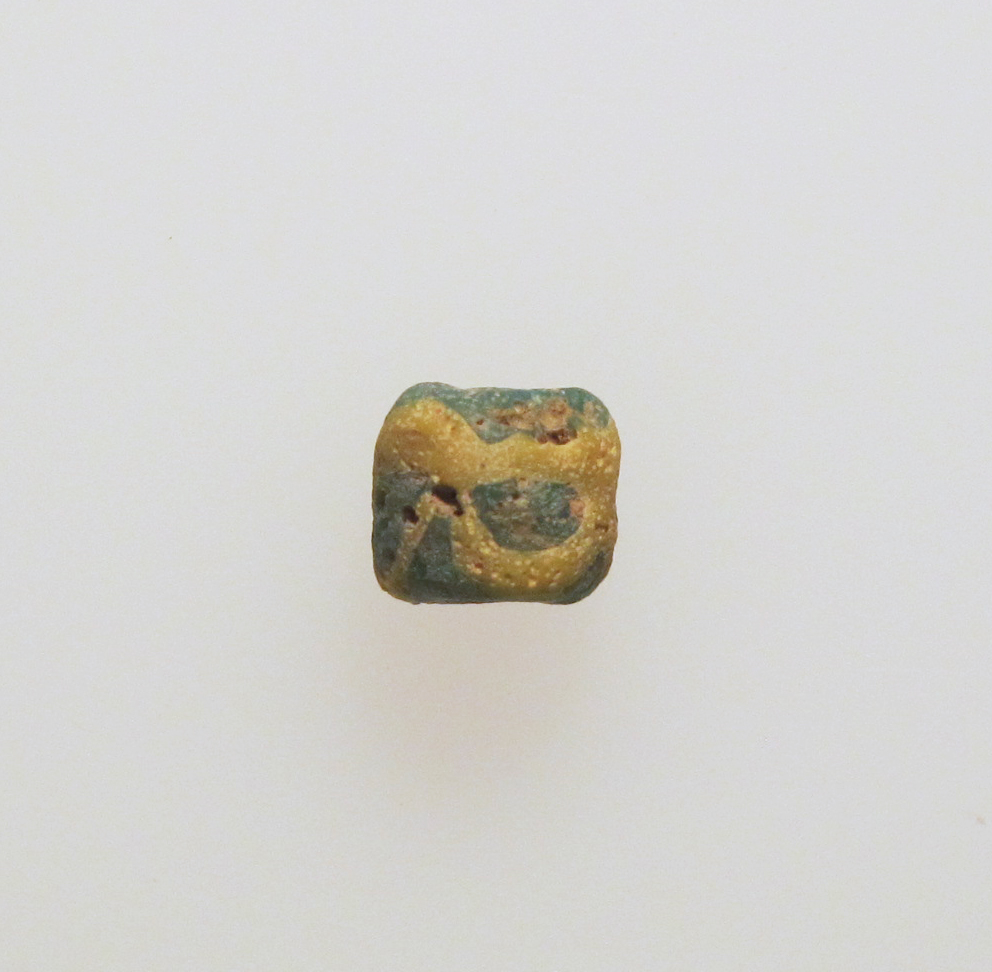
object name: bead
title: Glass bead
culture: roman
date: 101-400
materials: glass